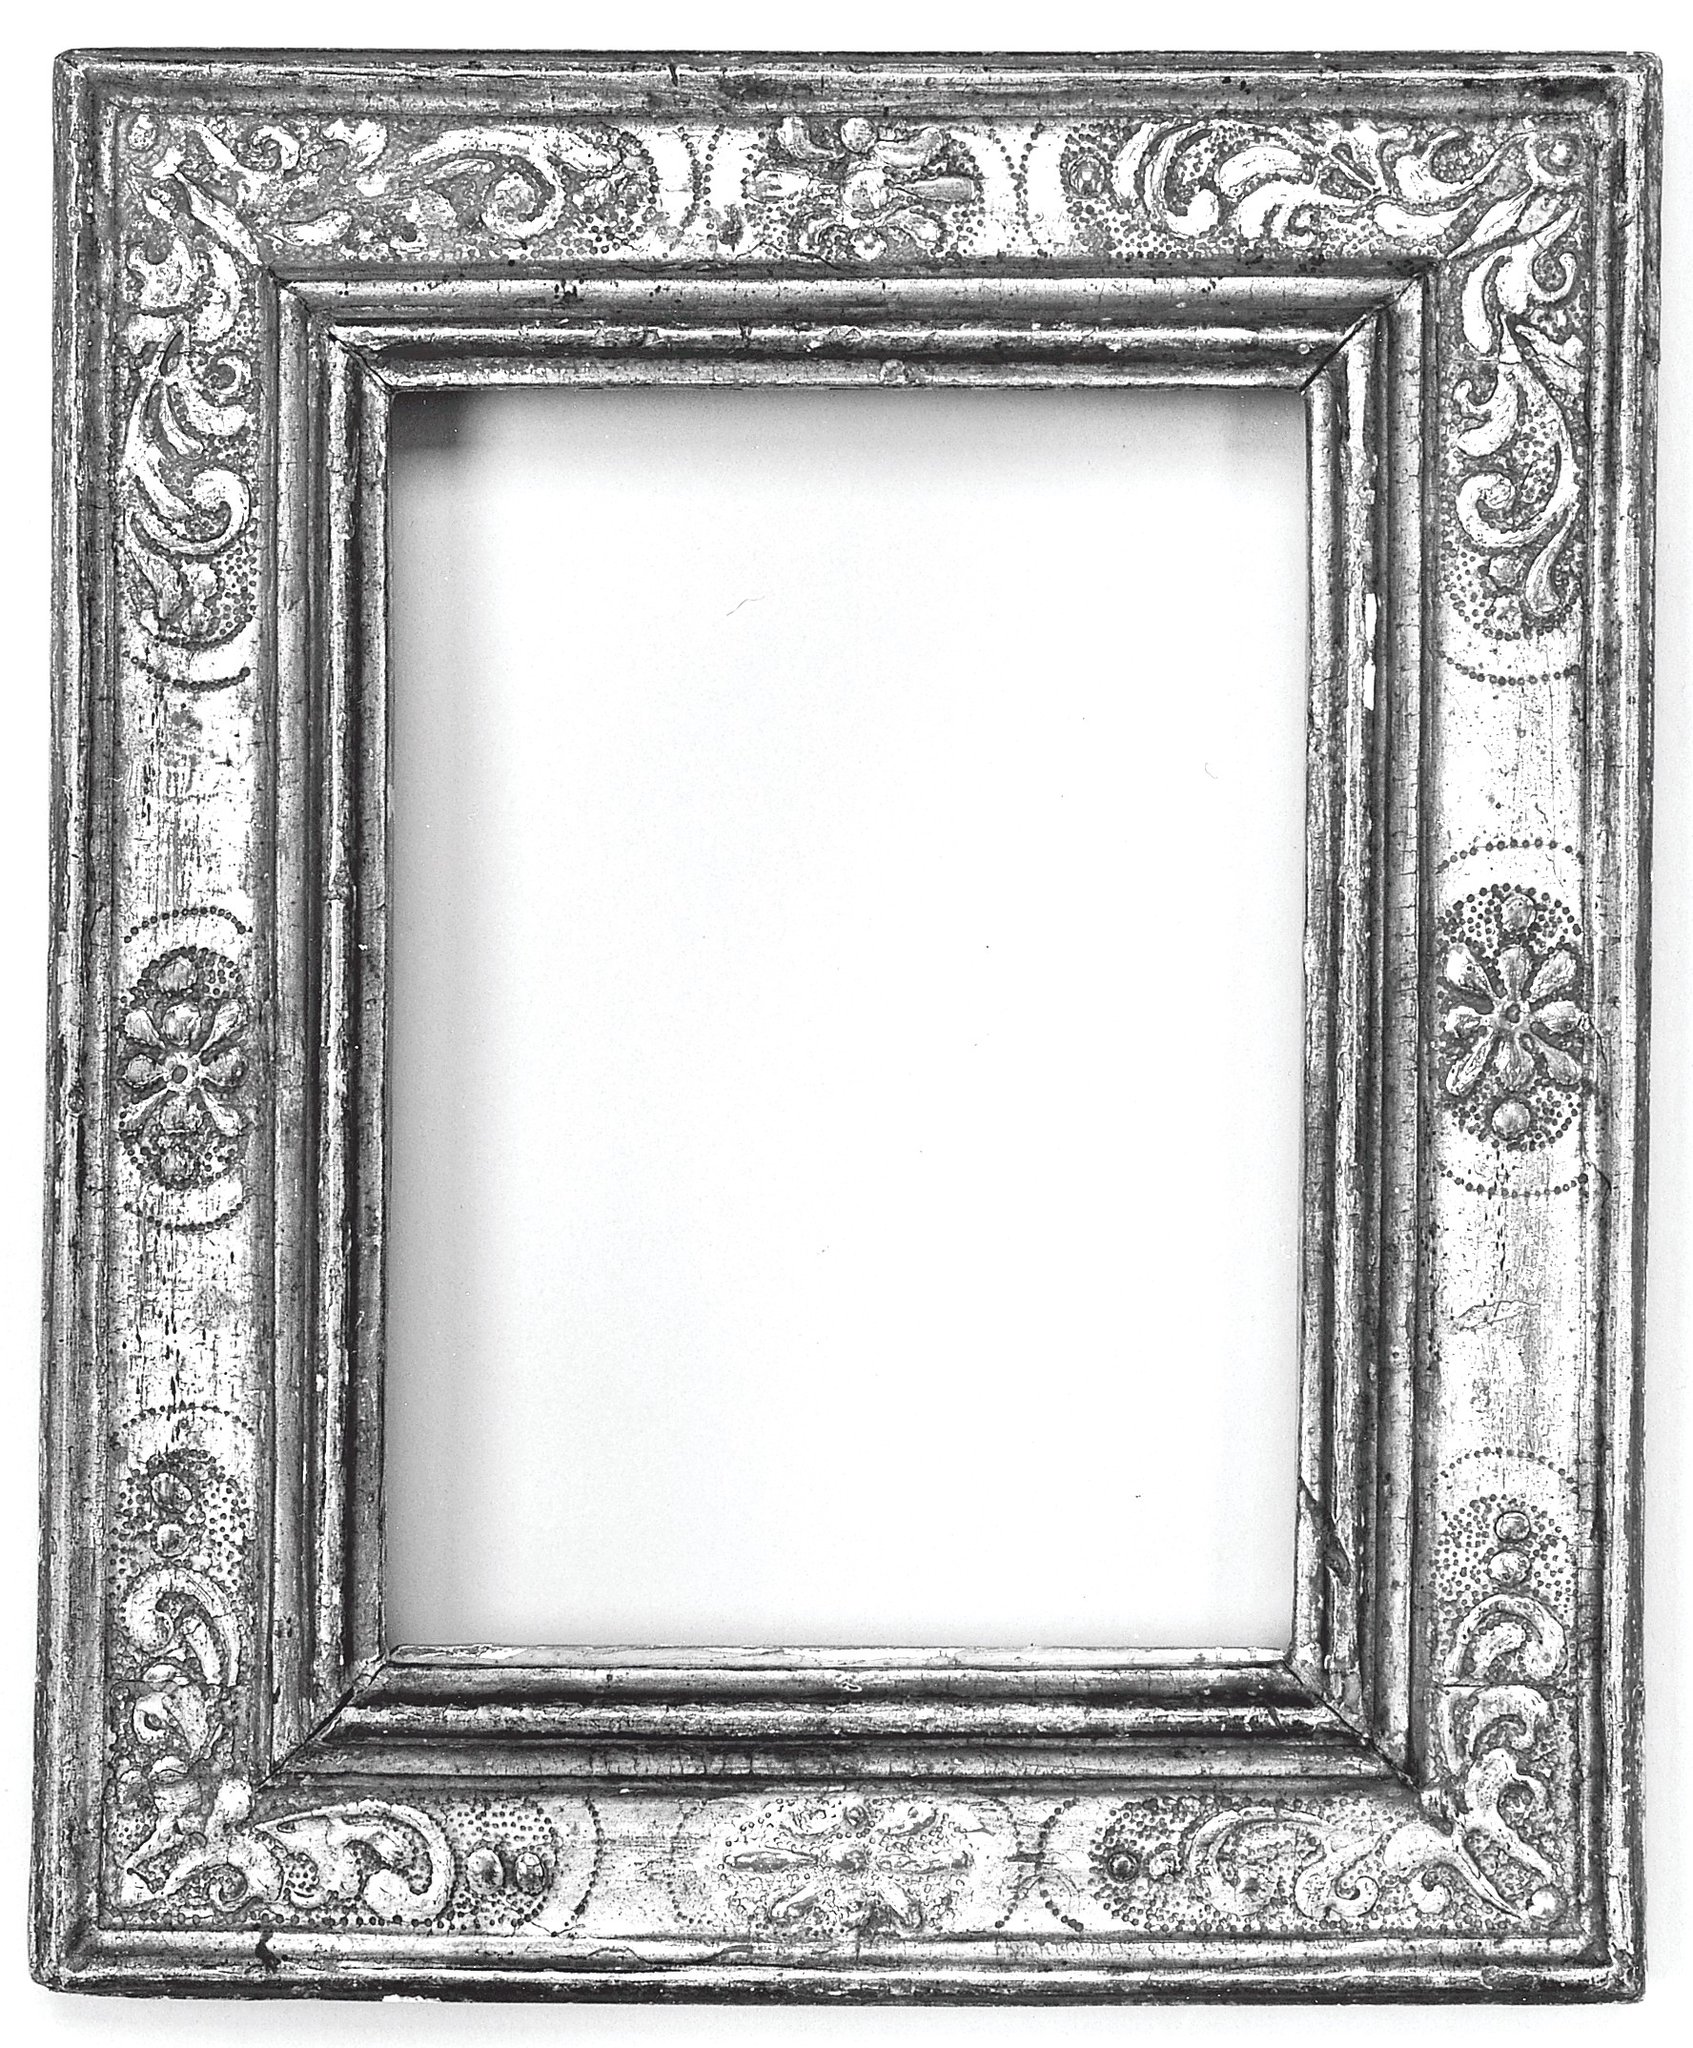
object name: frame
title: Cassetta frame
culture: italian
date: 1601-1633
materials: wood